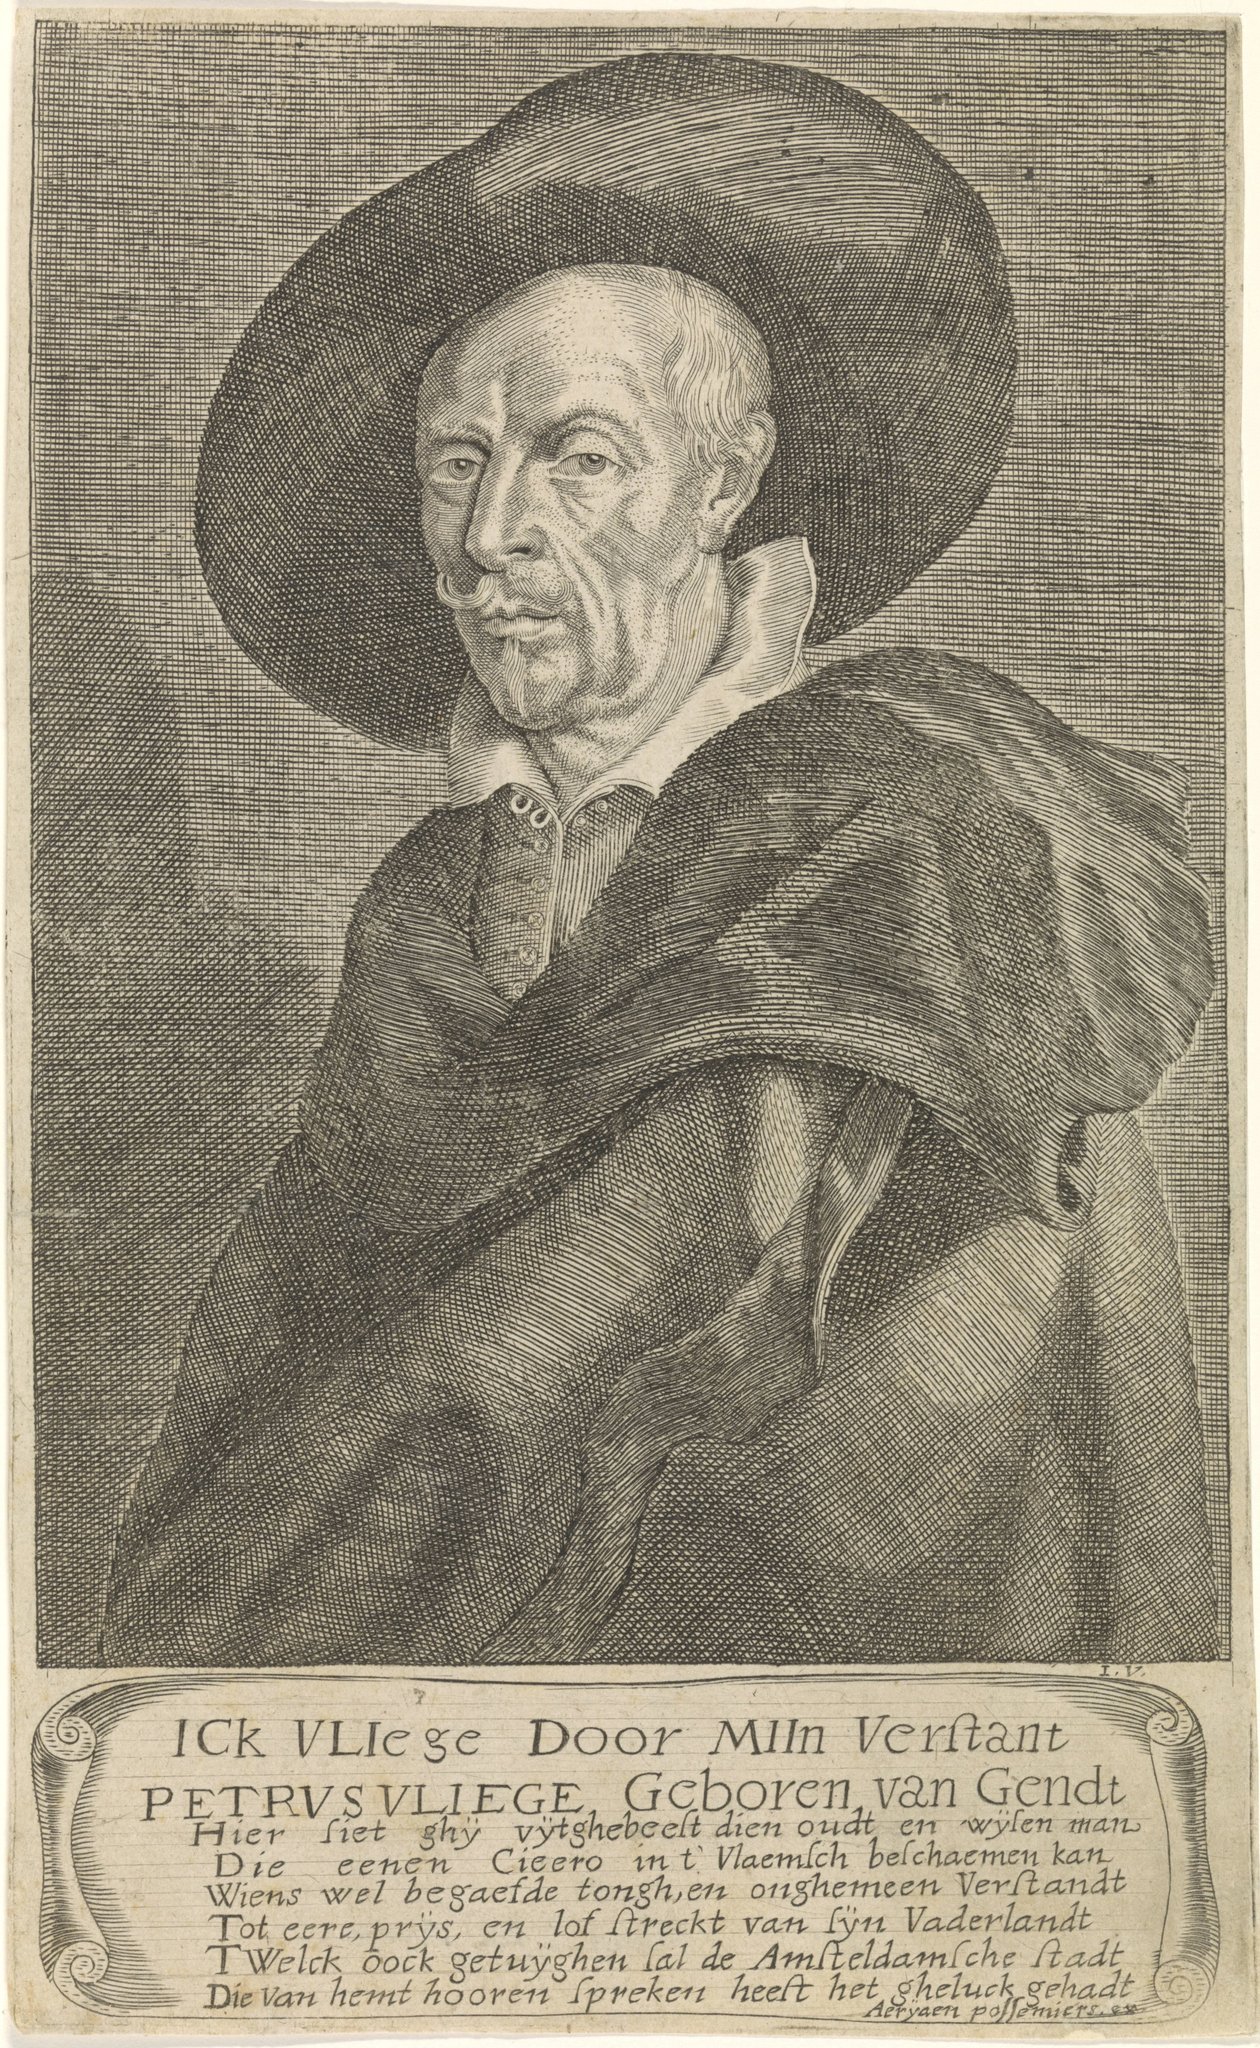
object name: print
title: Portret van de Vlaams letterkundige Petrus Vliege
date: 1662-1666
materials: paper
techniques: engraving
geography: southern netherlands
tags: dichter, schrijver, petrus vliege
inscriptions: collector's mark: Lugt 2228